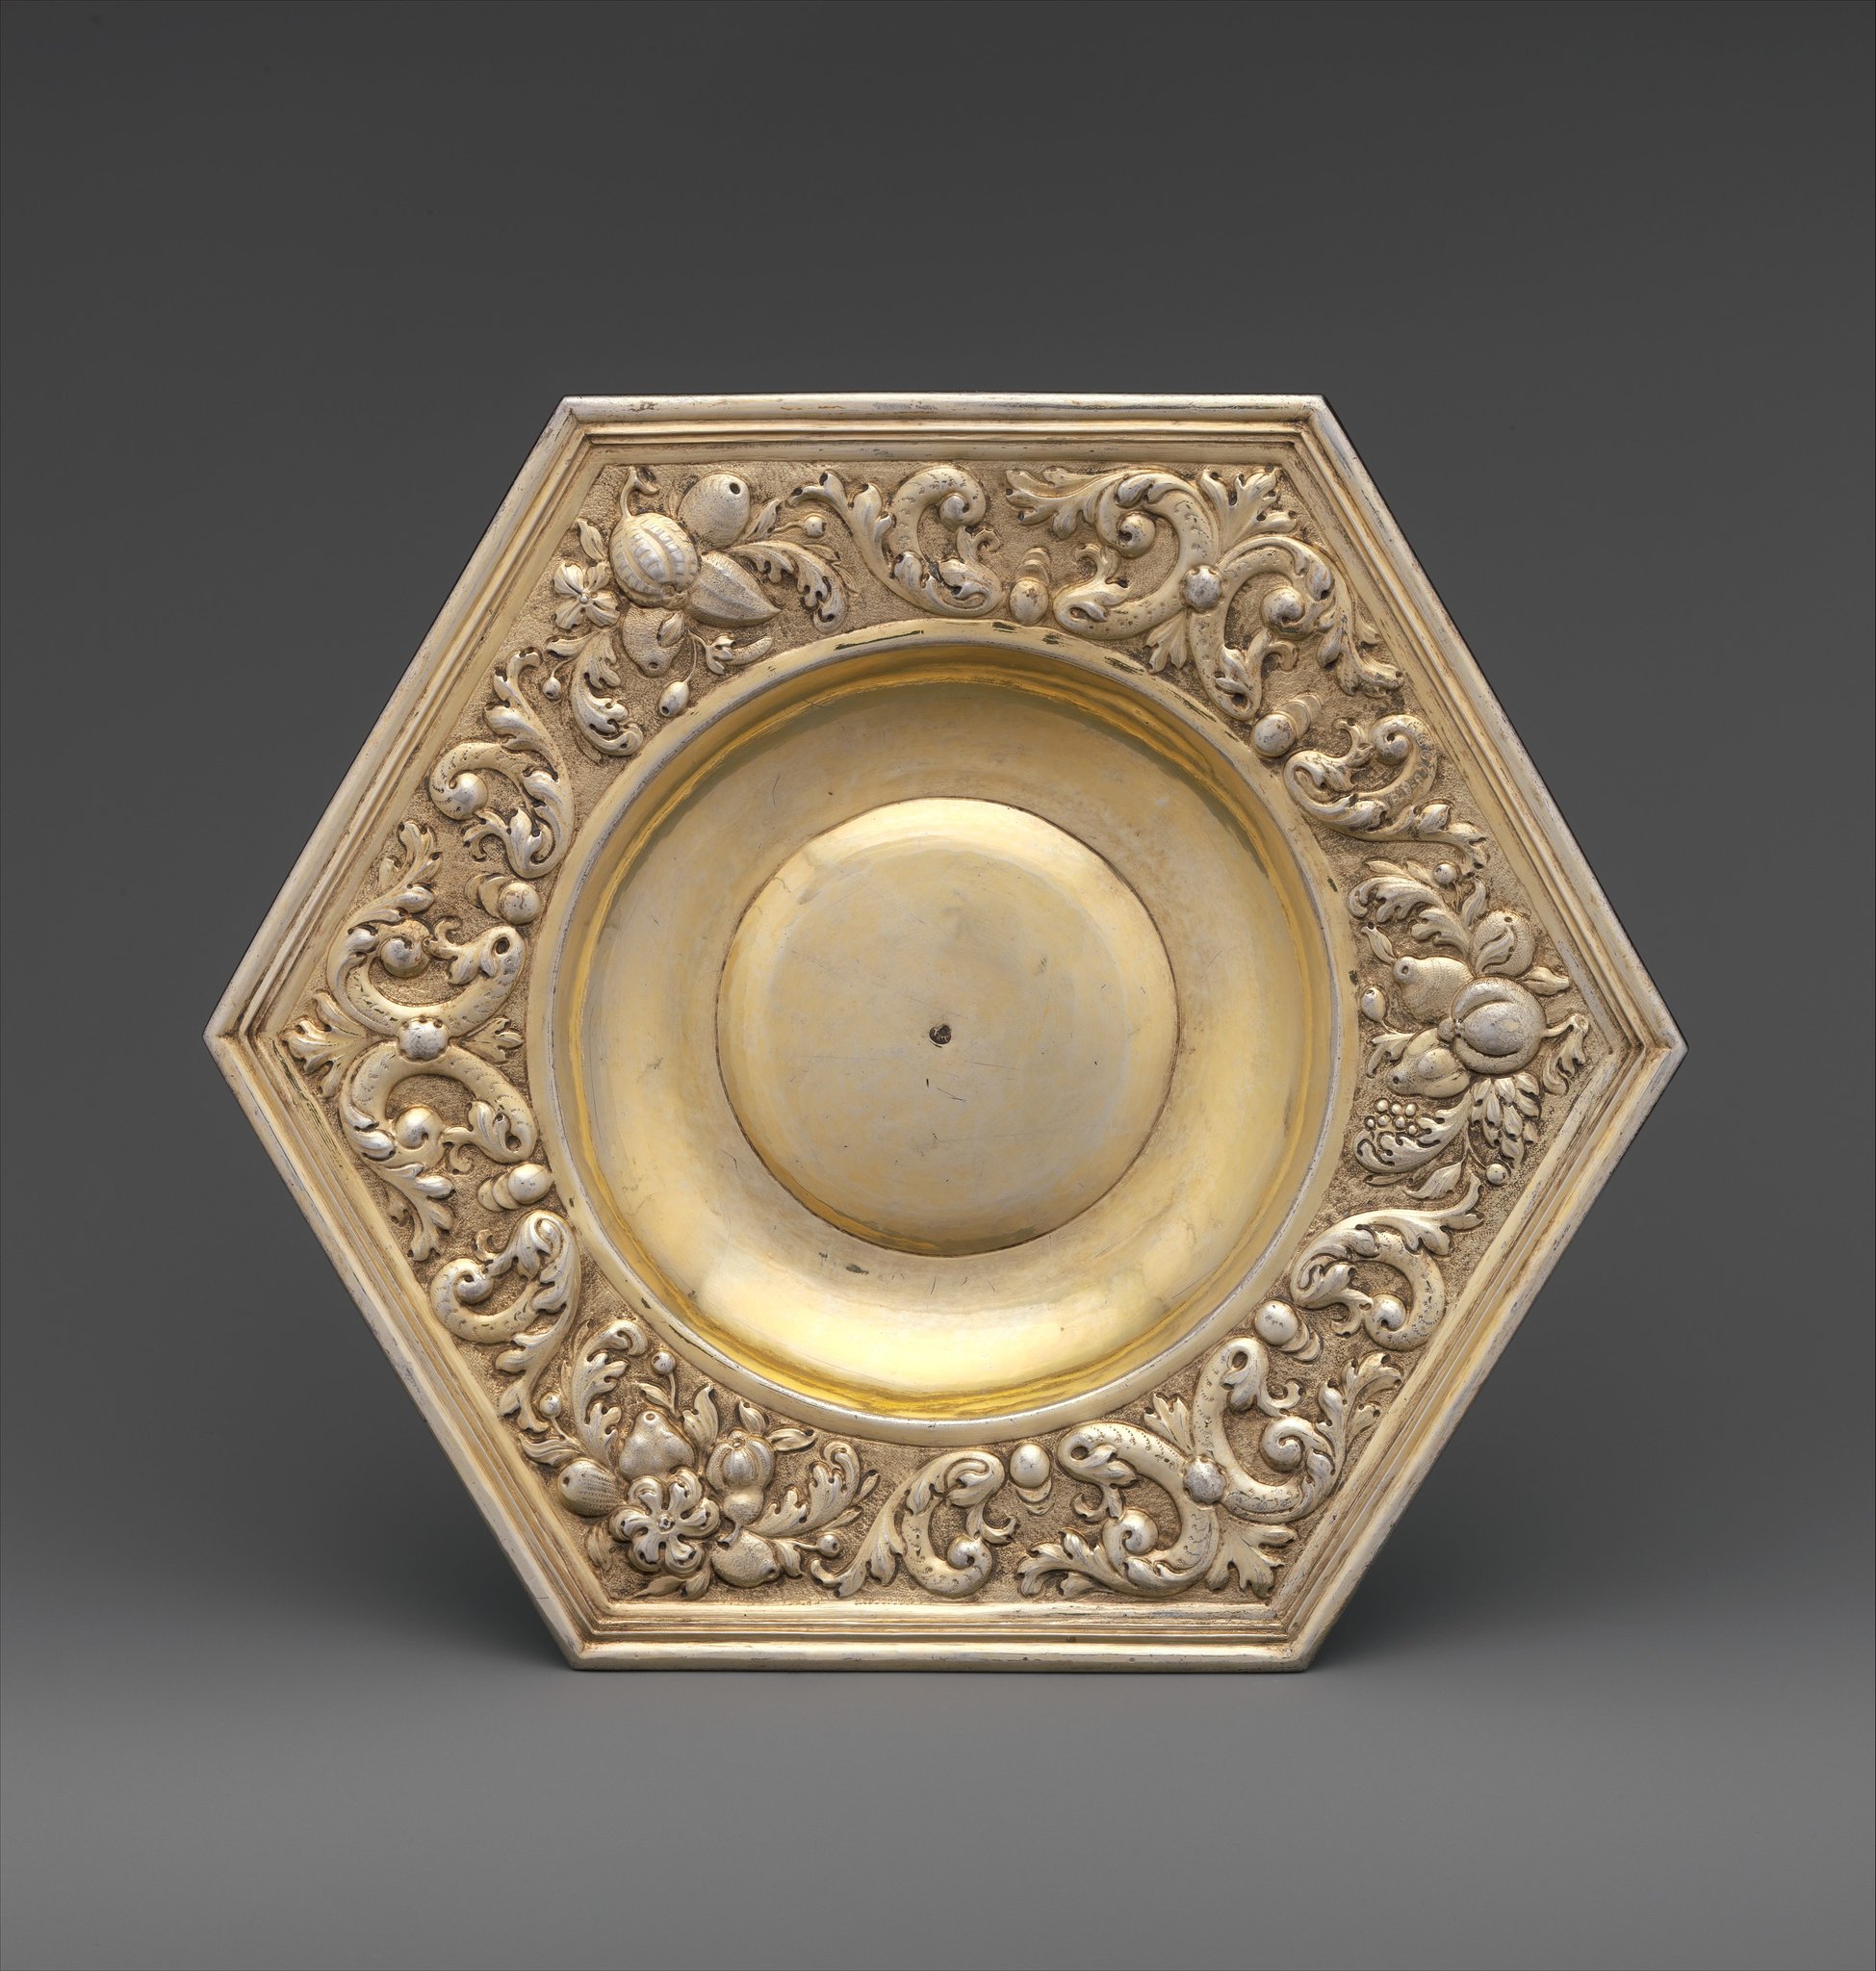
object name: dish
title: Hexagonal dish (part of a set)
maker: paulus roth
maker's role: maker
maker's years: 1589-1689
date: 1651-1700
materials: gilt silver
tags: flowers